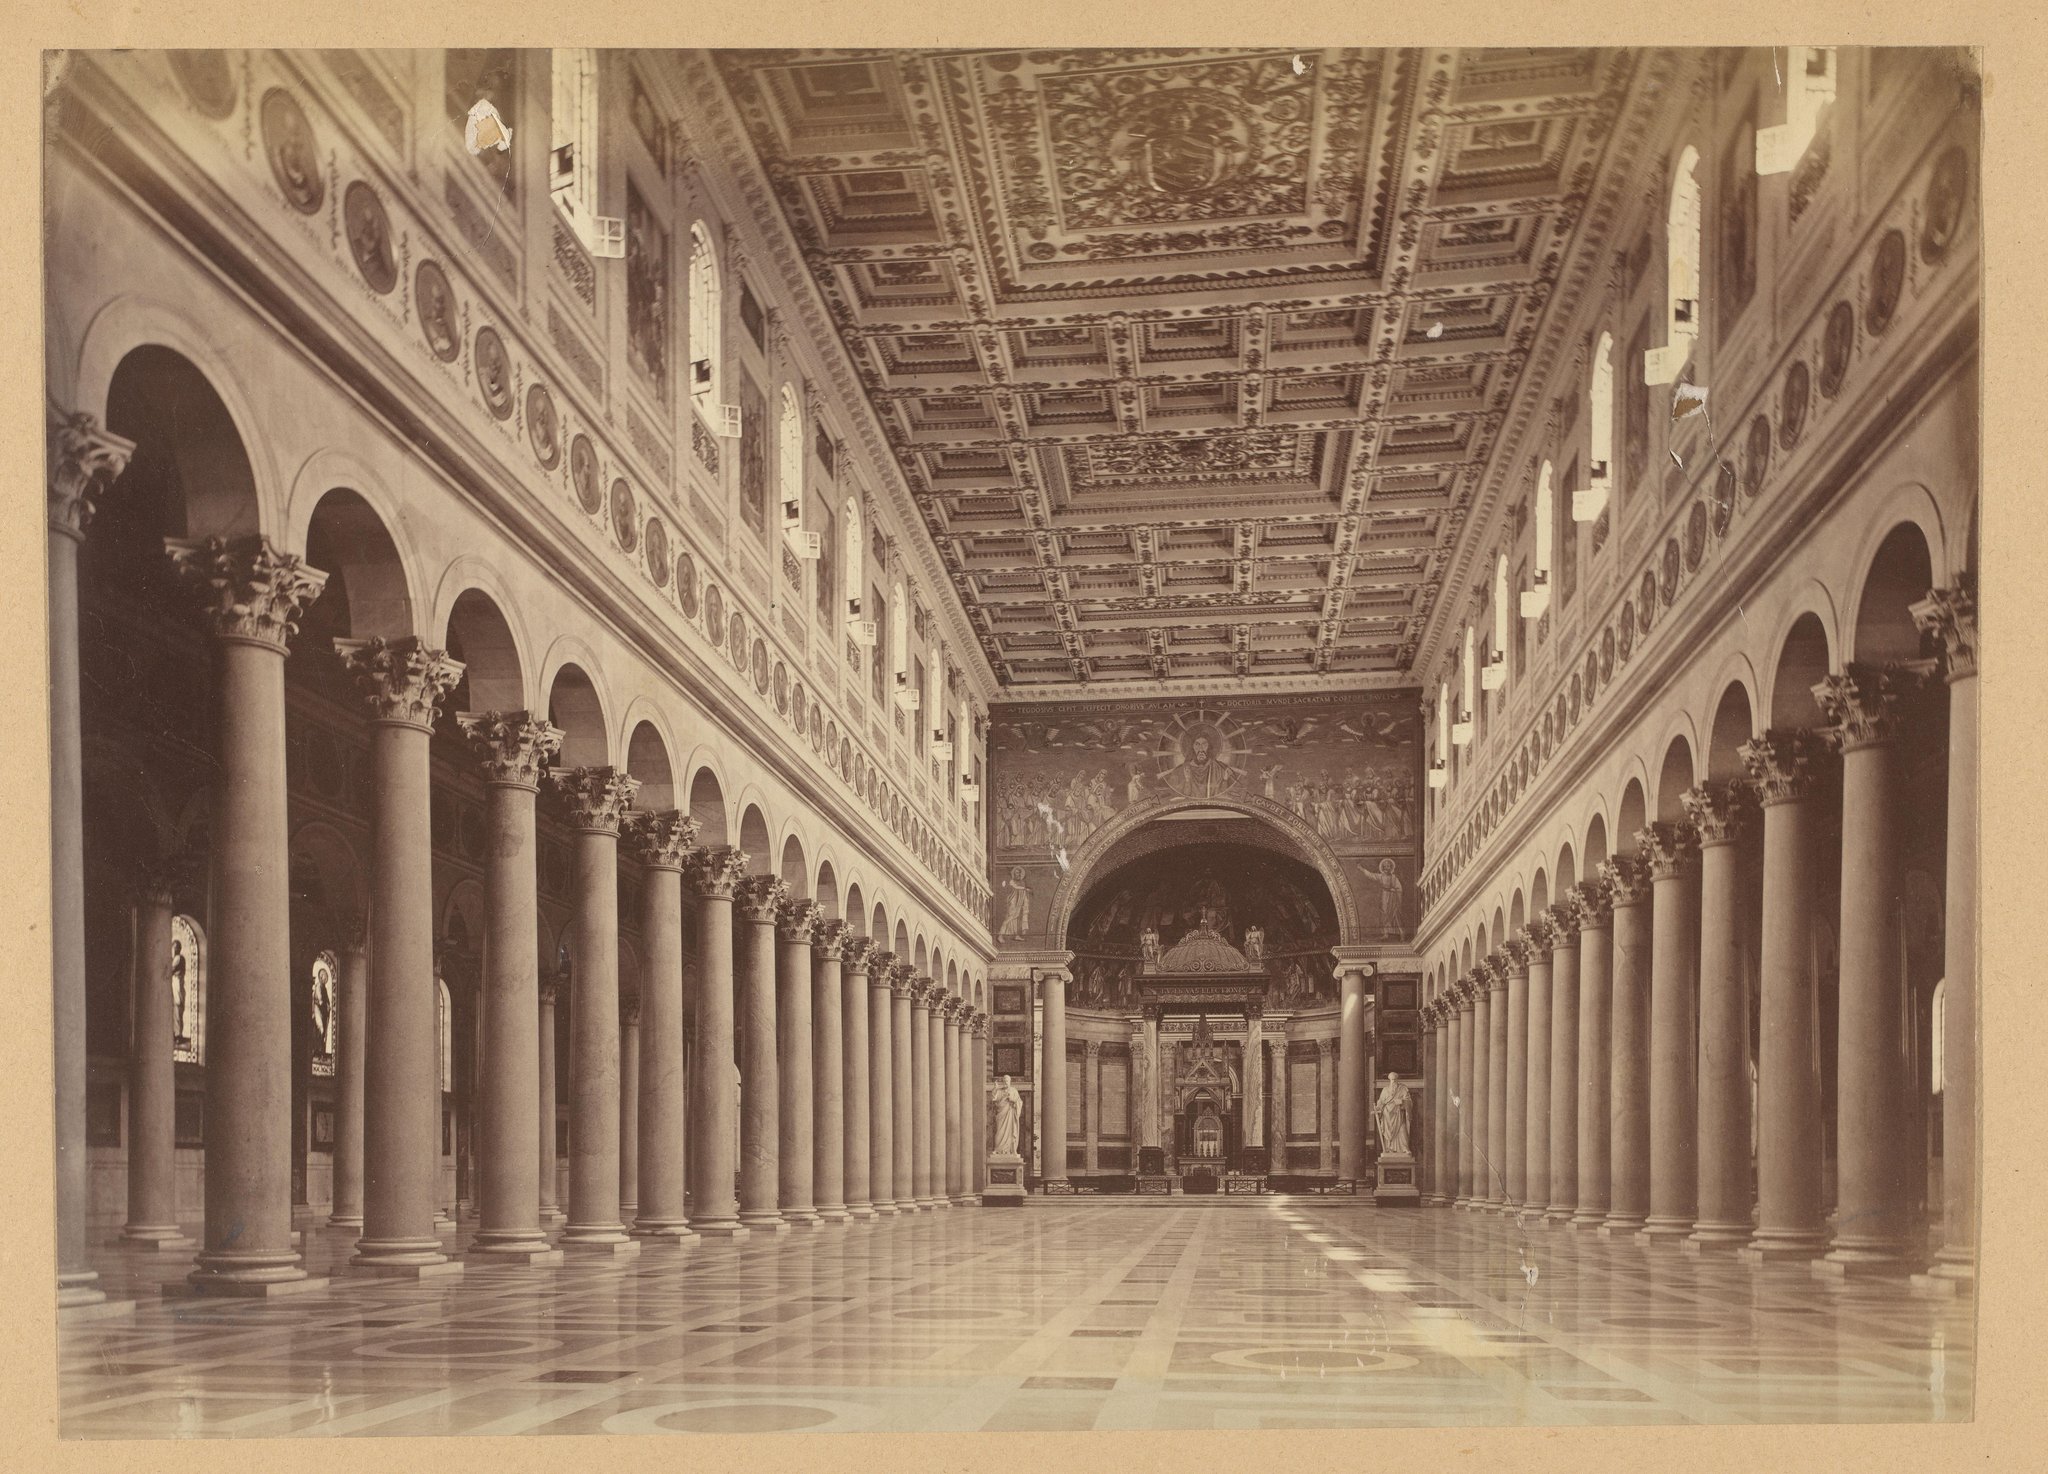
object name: photograph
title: Interieur van de Basiliek van Sint-Paulus buiten de Muren in Rome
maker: Anonymous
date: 1860-1900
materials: photographic support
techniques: albumen print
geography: sint-paulus buiten de muren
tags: colonnade, interior of church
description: Onderdeel van Reisalbum met opnames van kunstwerken en bezienswaardigheden in Italië, Griekenland en Frankrijk.